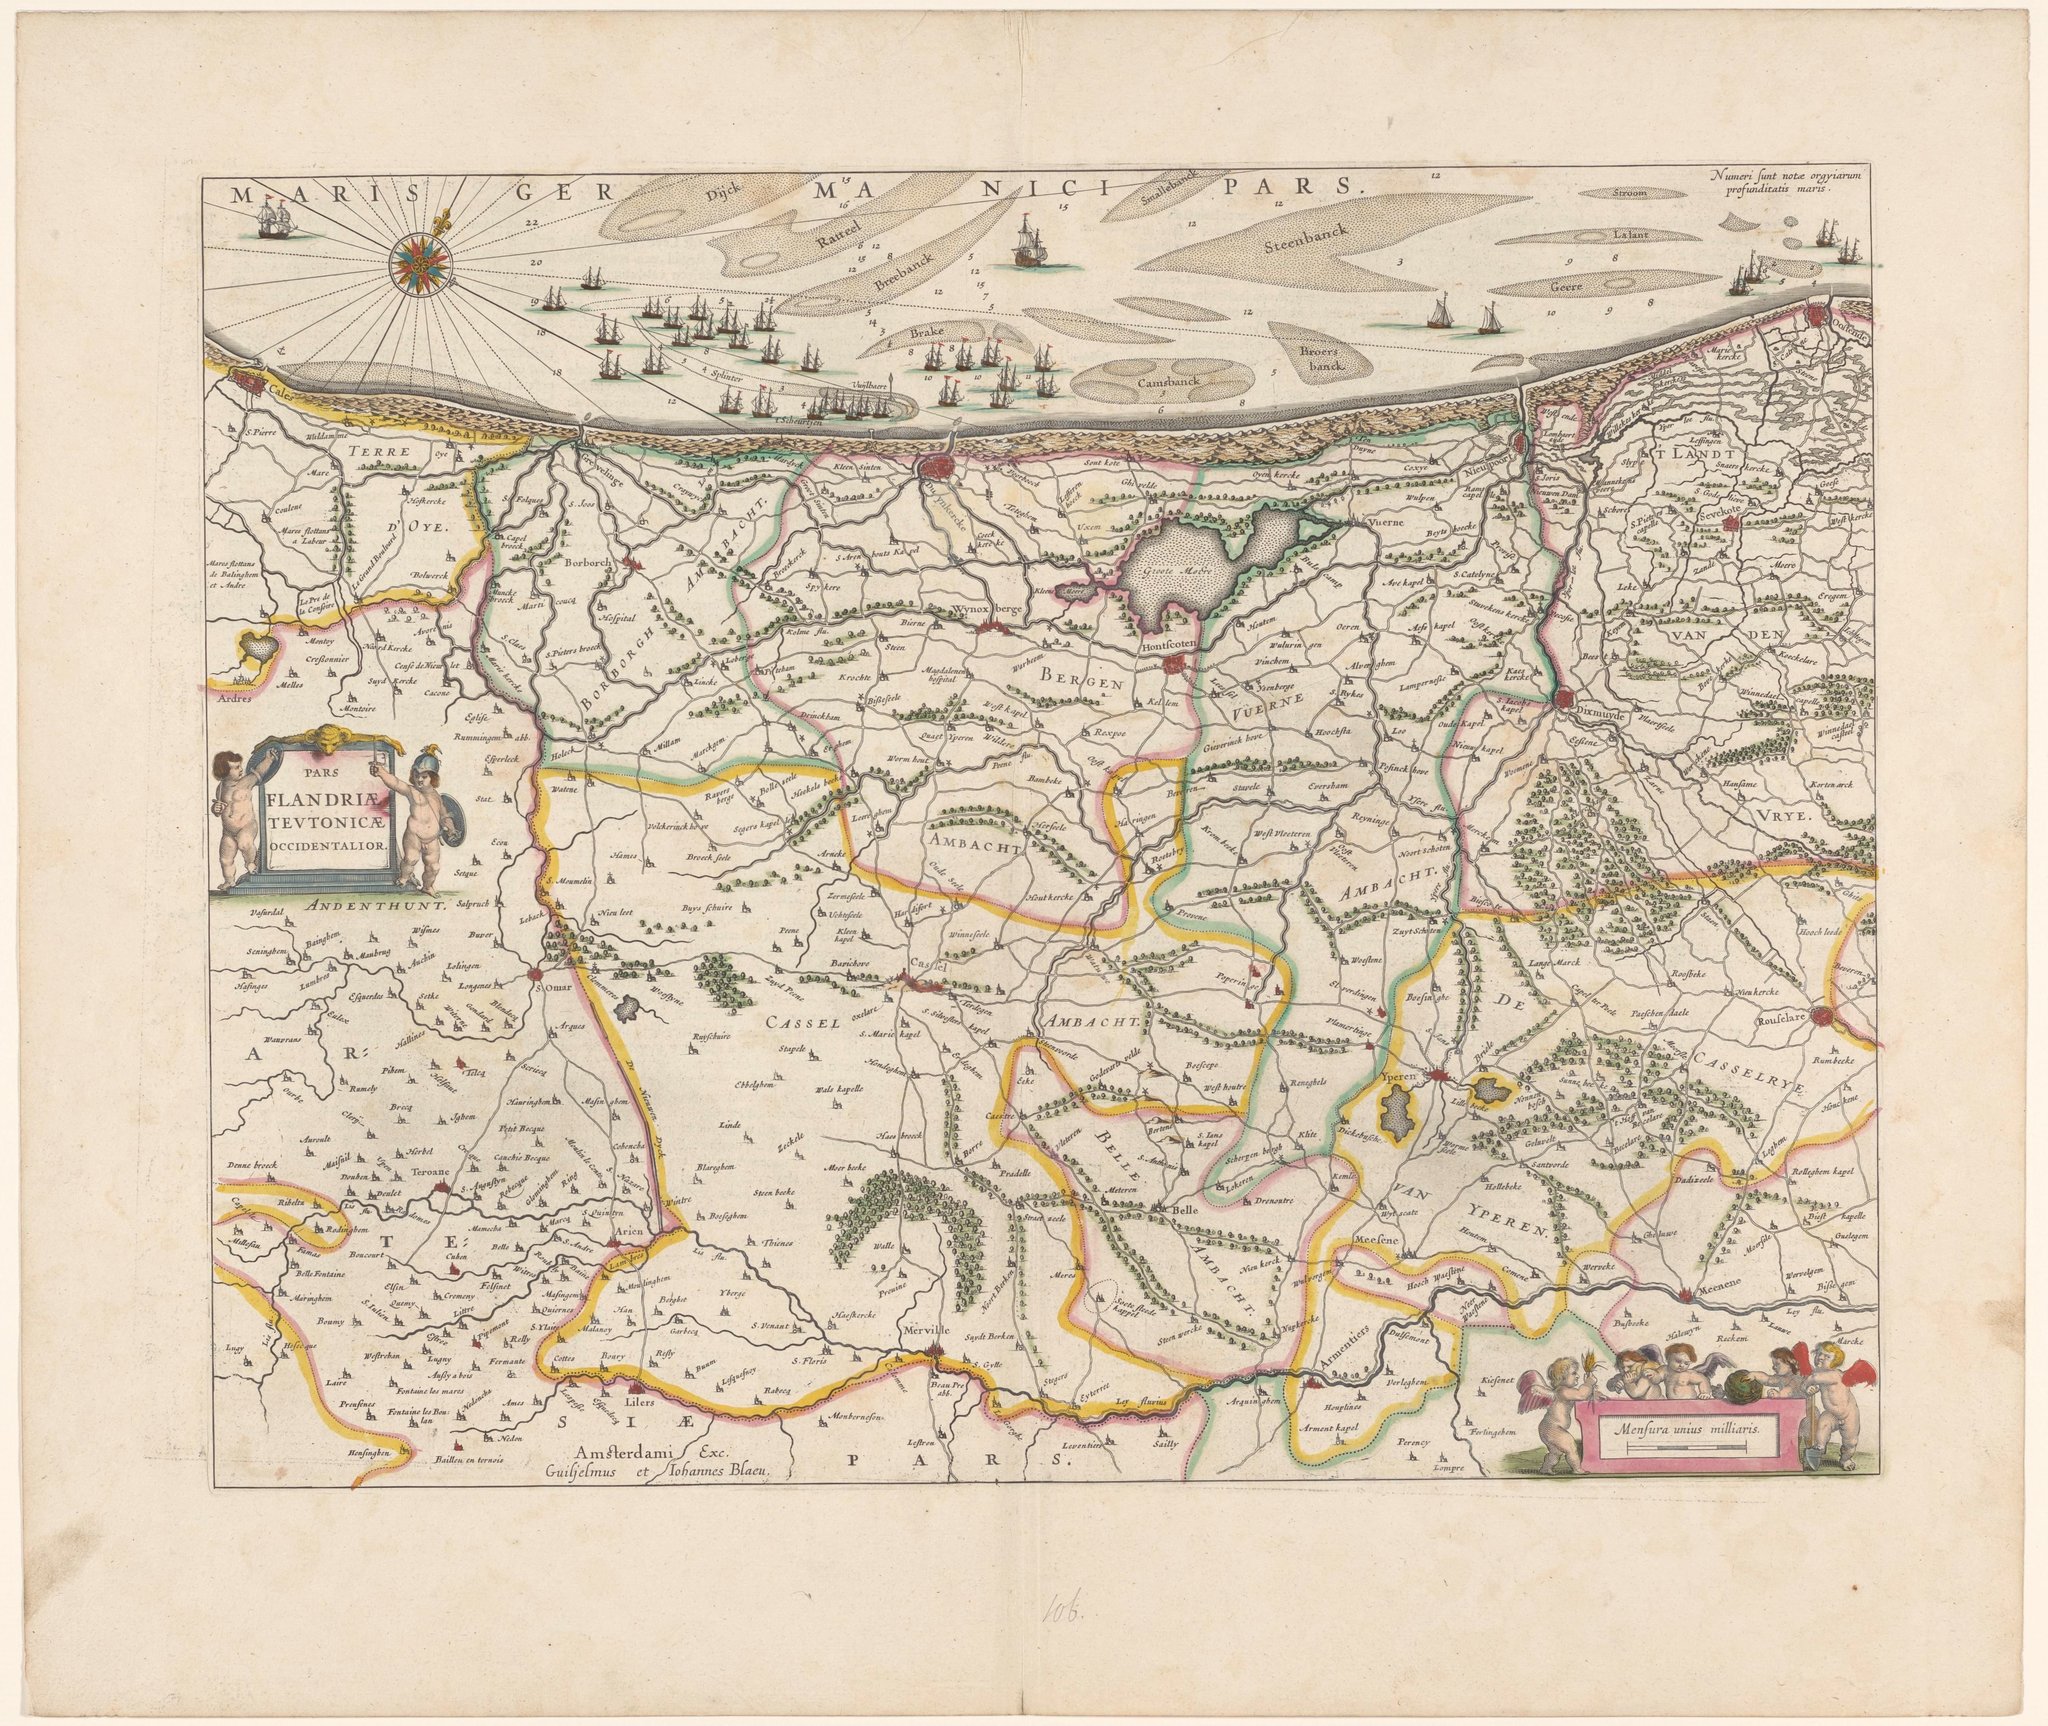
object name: map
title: Kaart van het westelijk deel van Vlaanderen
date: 1635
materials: paper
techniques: engraving, etching, hand coloring, letterpress printing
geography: amsterdam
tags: maps of separate countries or regions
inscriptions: collector's mark: Lugt 2228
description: Prent gebruikt in: Blaeu, Willem Janszoon en Johannes Willemszoon Blaeu. Toonneel des Aerdrycx, ofte nieuwe Atlas, dat is de beschryving van alle landen. 2 delen. Amsterdam: Willem Janszoon en Johannes Willemszoon Blaeu, 1635, dl. 1.